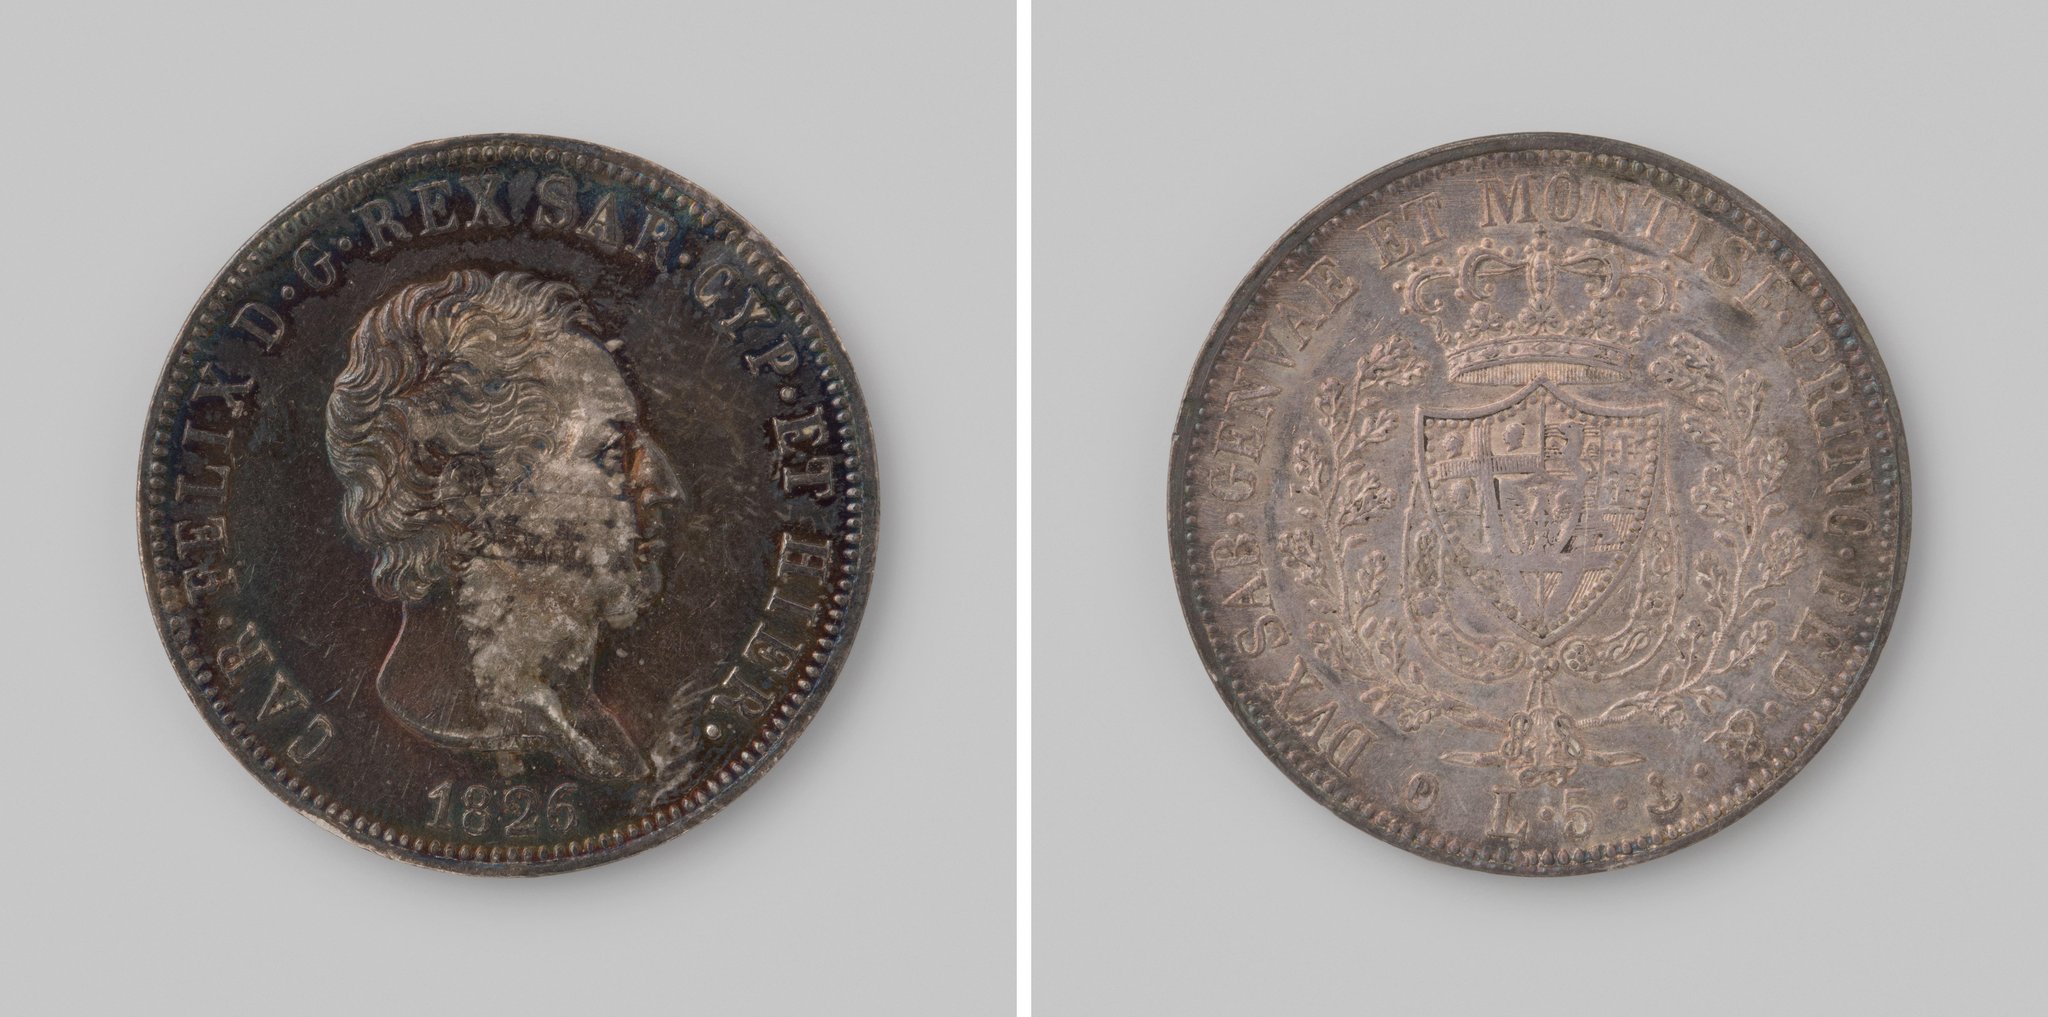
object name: coin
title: Sardinië, koning Carlo Felice, 5 lire, 1826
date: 1826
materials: silver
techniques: striking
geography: genoa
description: Zilveren munt. Voorzijde: hoofd van de koning naar rechts. Daaronder jaartal. Keerzijde: binnen twee takken door keten van ridderorde met juweel omhangen gekroond samengesteld wapenschild. Waarde-aanduiding onderaan in omschrift. Rechts daarvan muntteken: anker [=Genua]. Randschrift.